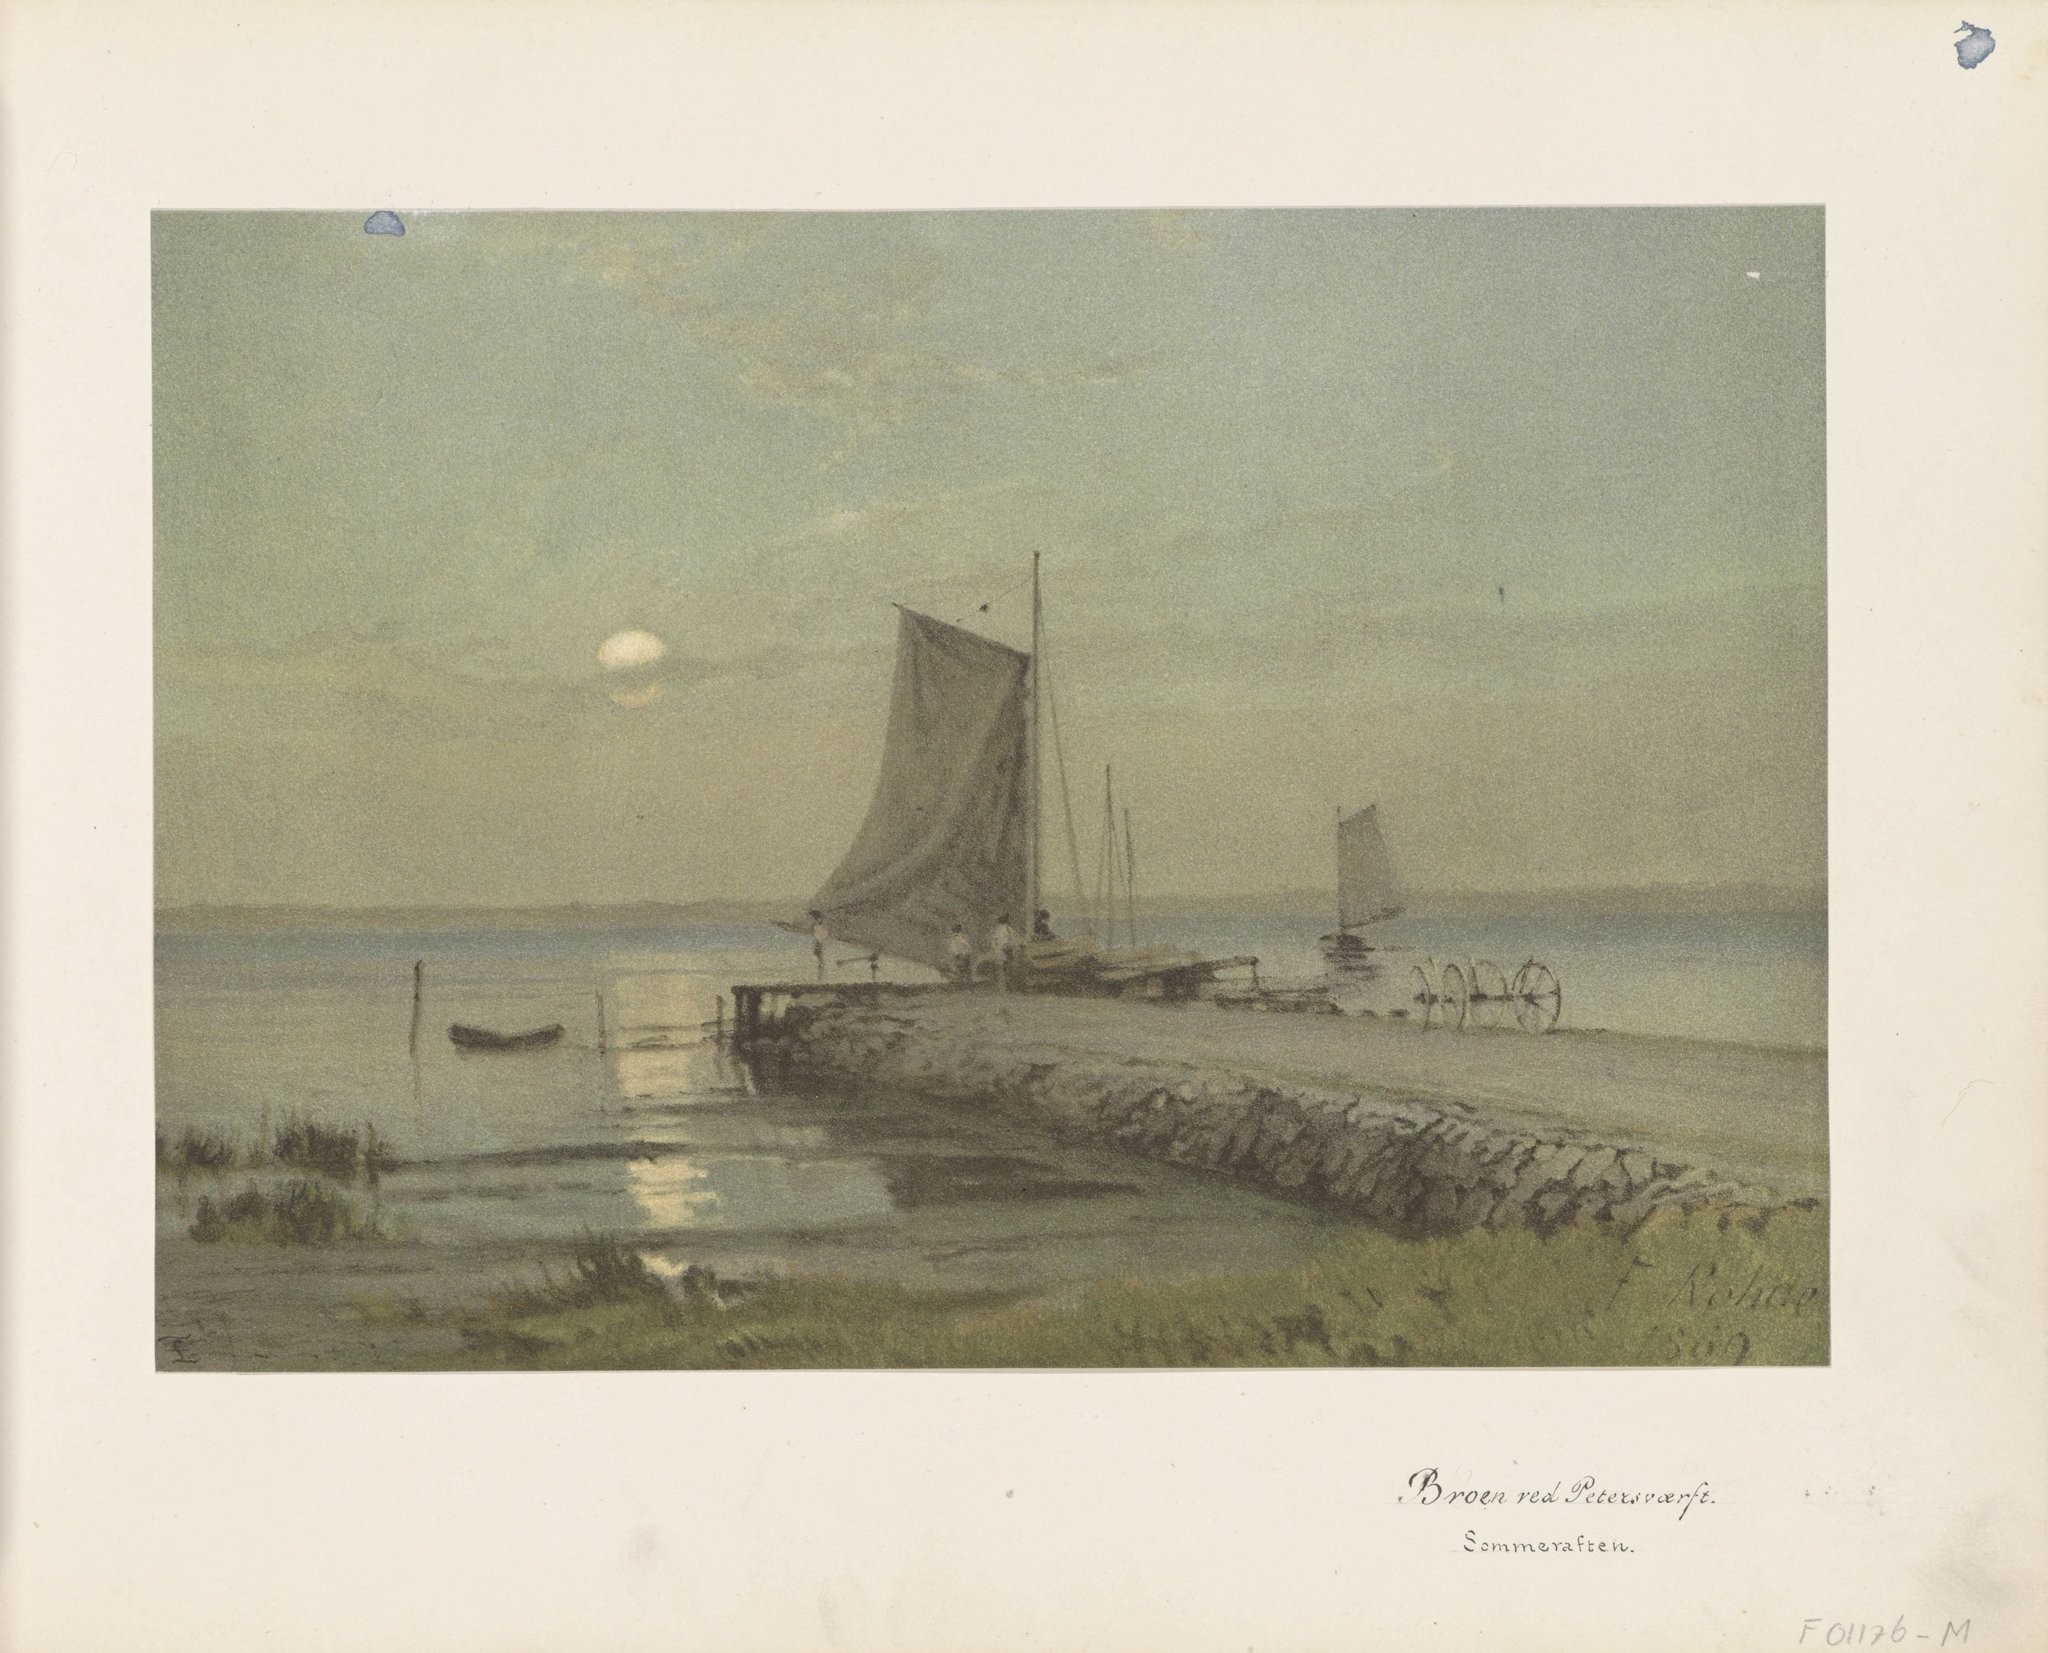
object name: print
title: Zeegezicht naar een schilderij van F. Rohde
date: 1867-1876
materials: paper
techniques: chromolithography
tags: landscapes with waters, waterscapes, seascapes (in the temperate zone), travelling; tourism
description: Onderdeel van Reisalbum met foto's en tekeningen van Manuel Mayo 1876.